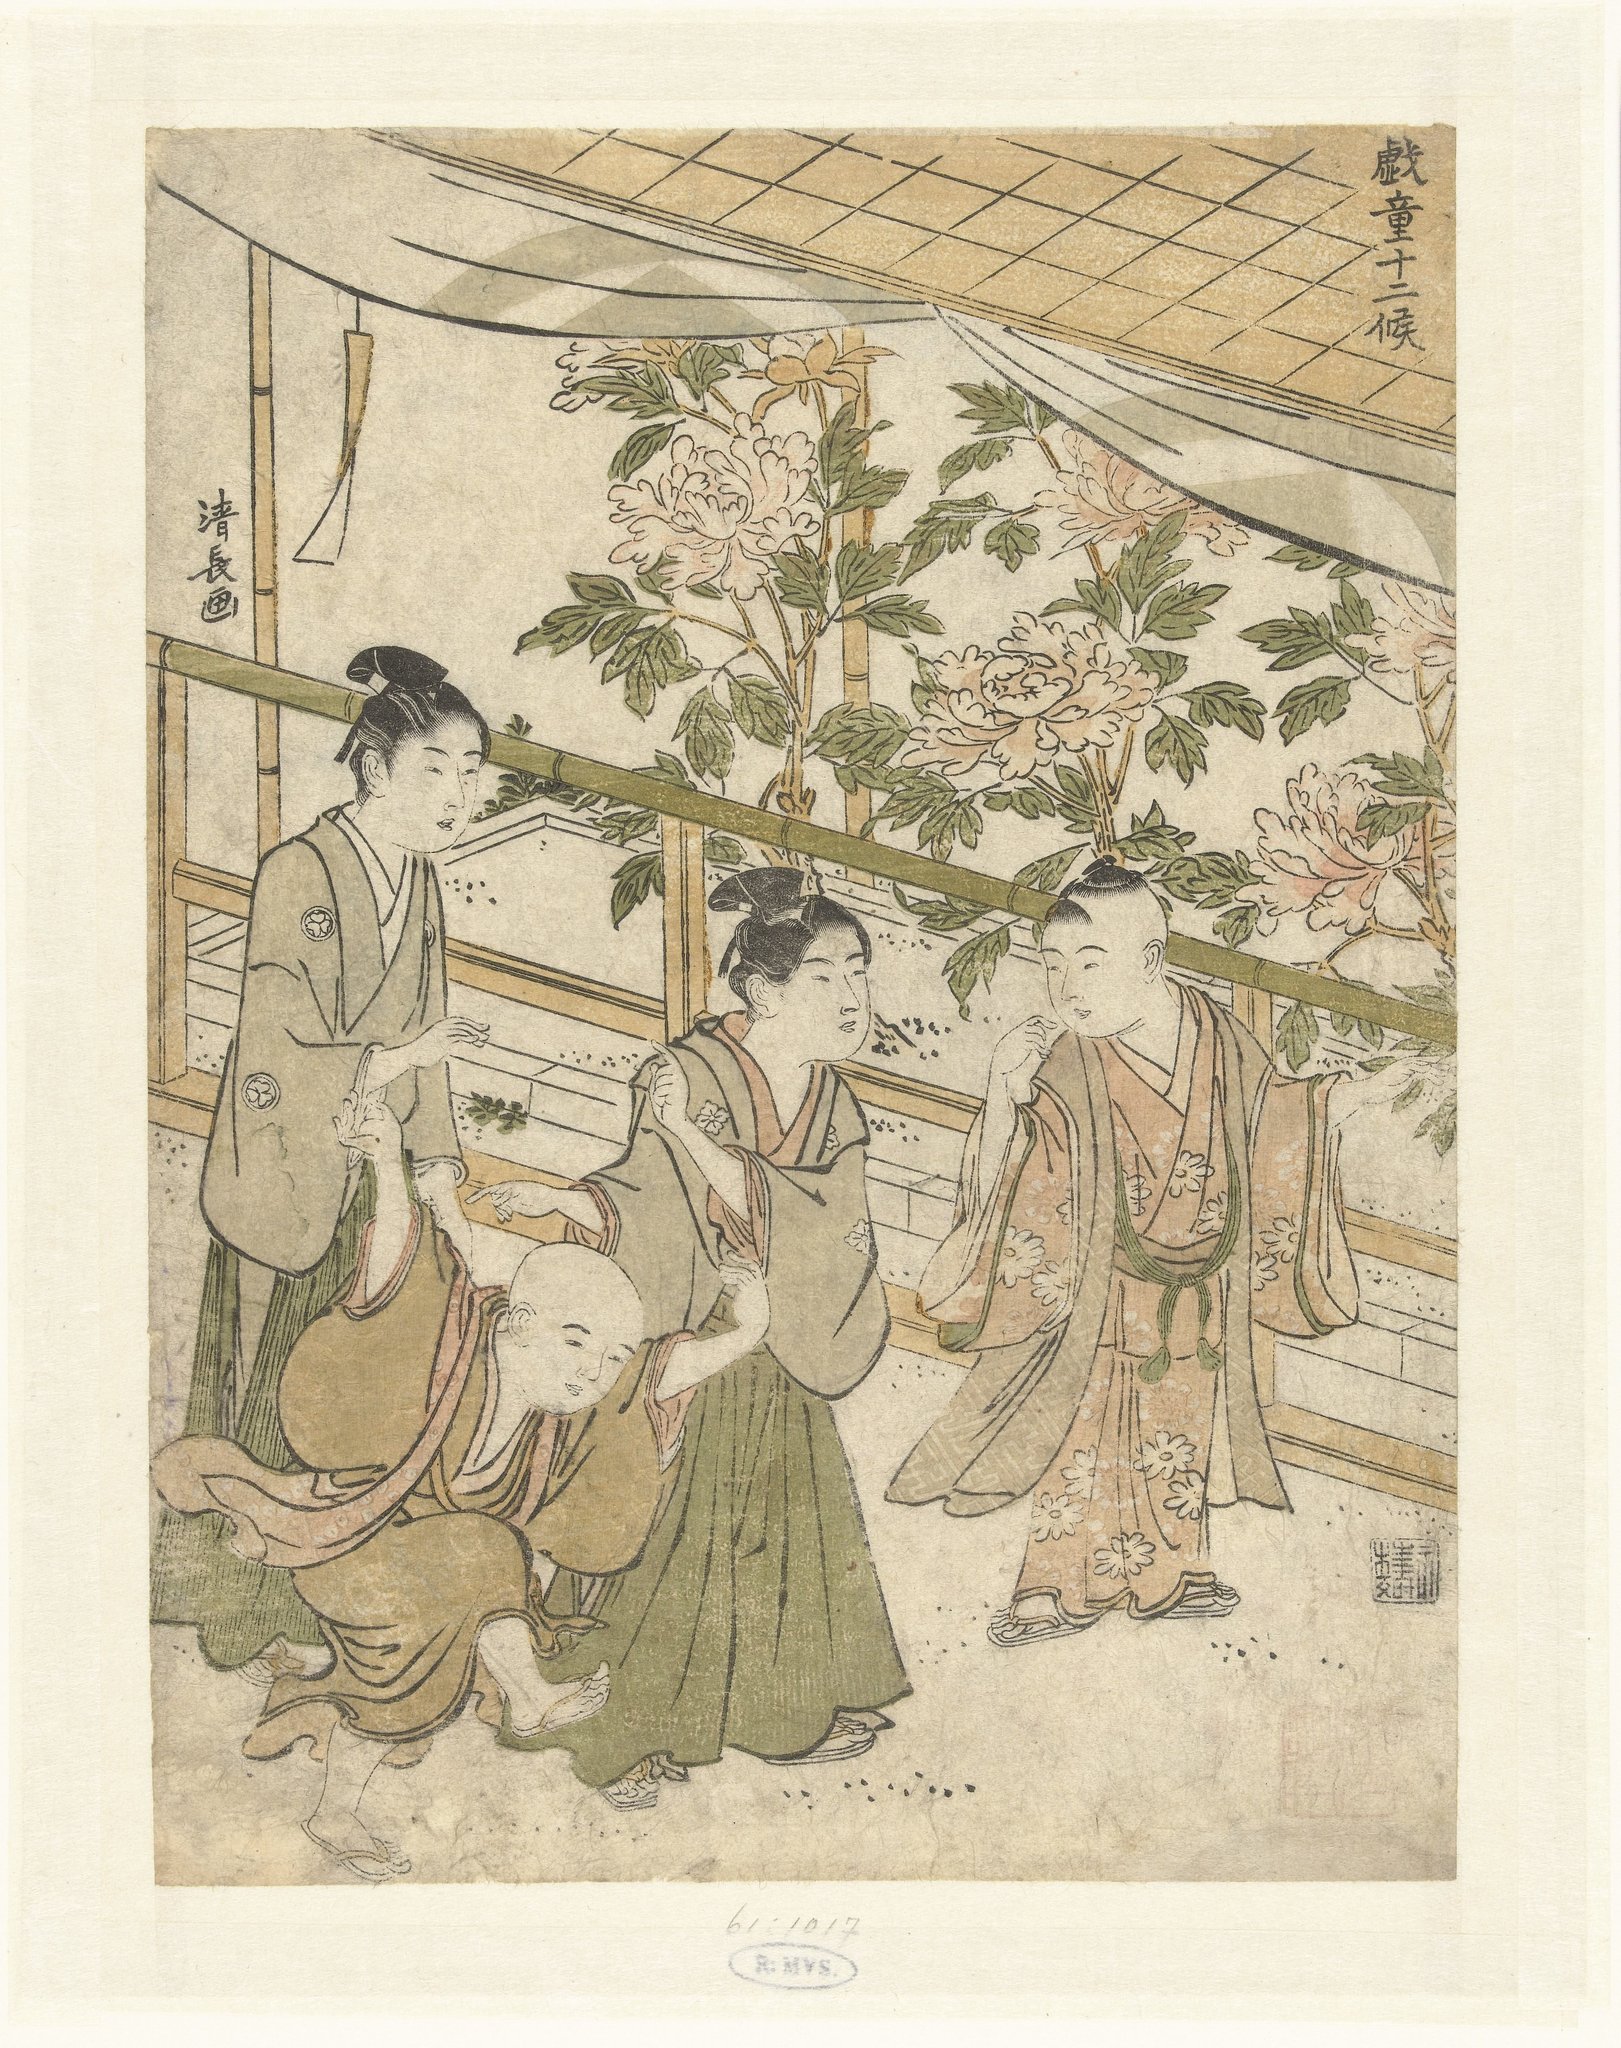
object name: print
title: Vier jongens spelend bij een perkje met pioenrozen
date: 1781-1785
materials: paper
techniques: woodcut, nishiki e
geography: japan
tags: children's games and plays, plants and herbs: peony, youth, adolescent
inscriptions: collector's mark: ‘Shibui Shintei’, collector's mark: Lugt 2228